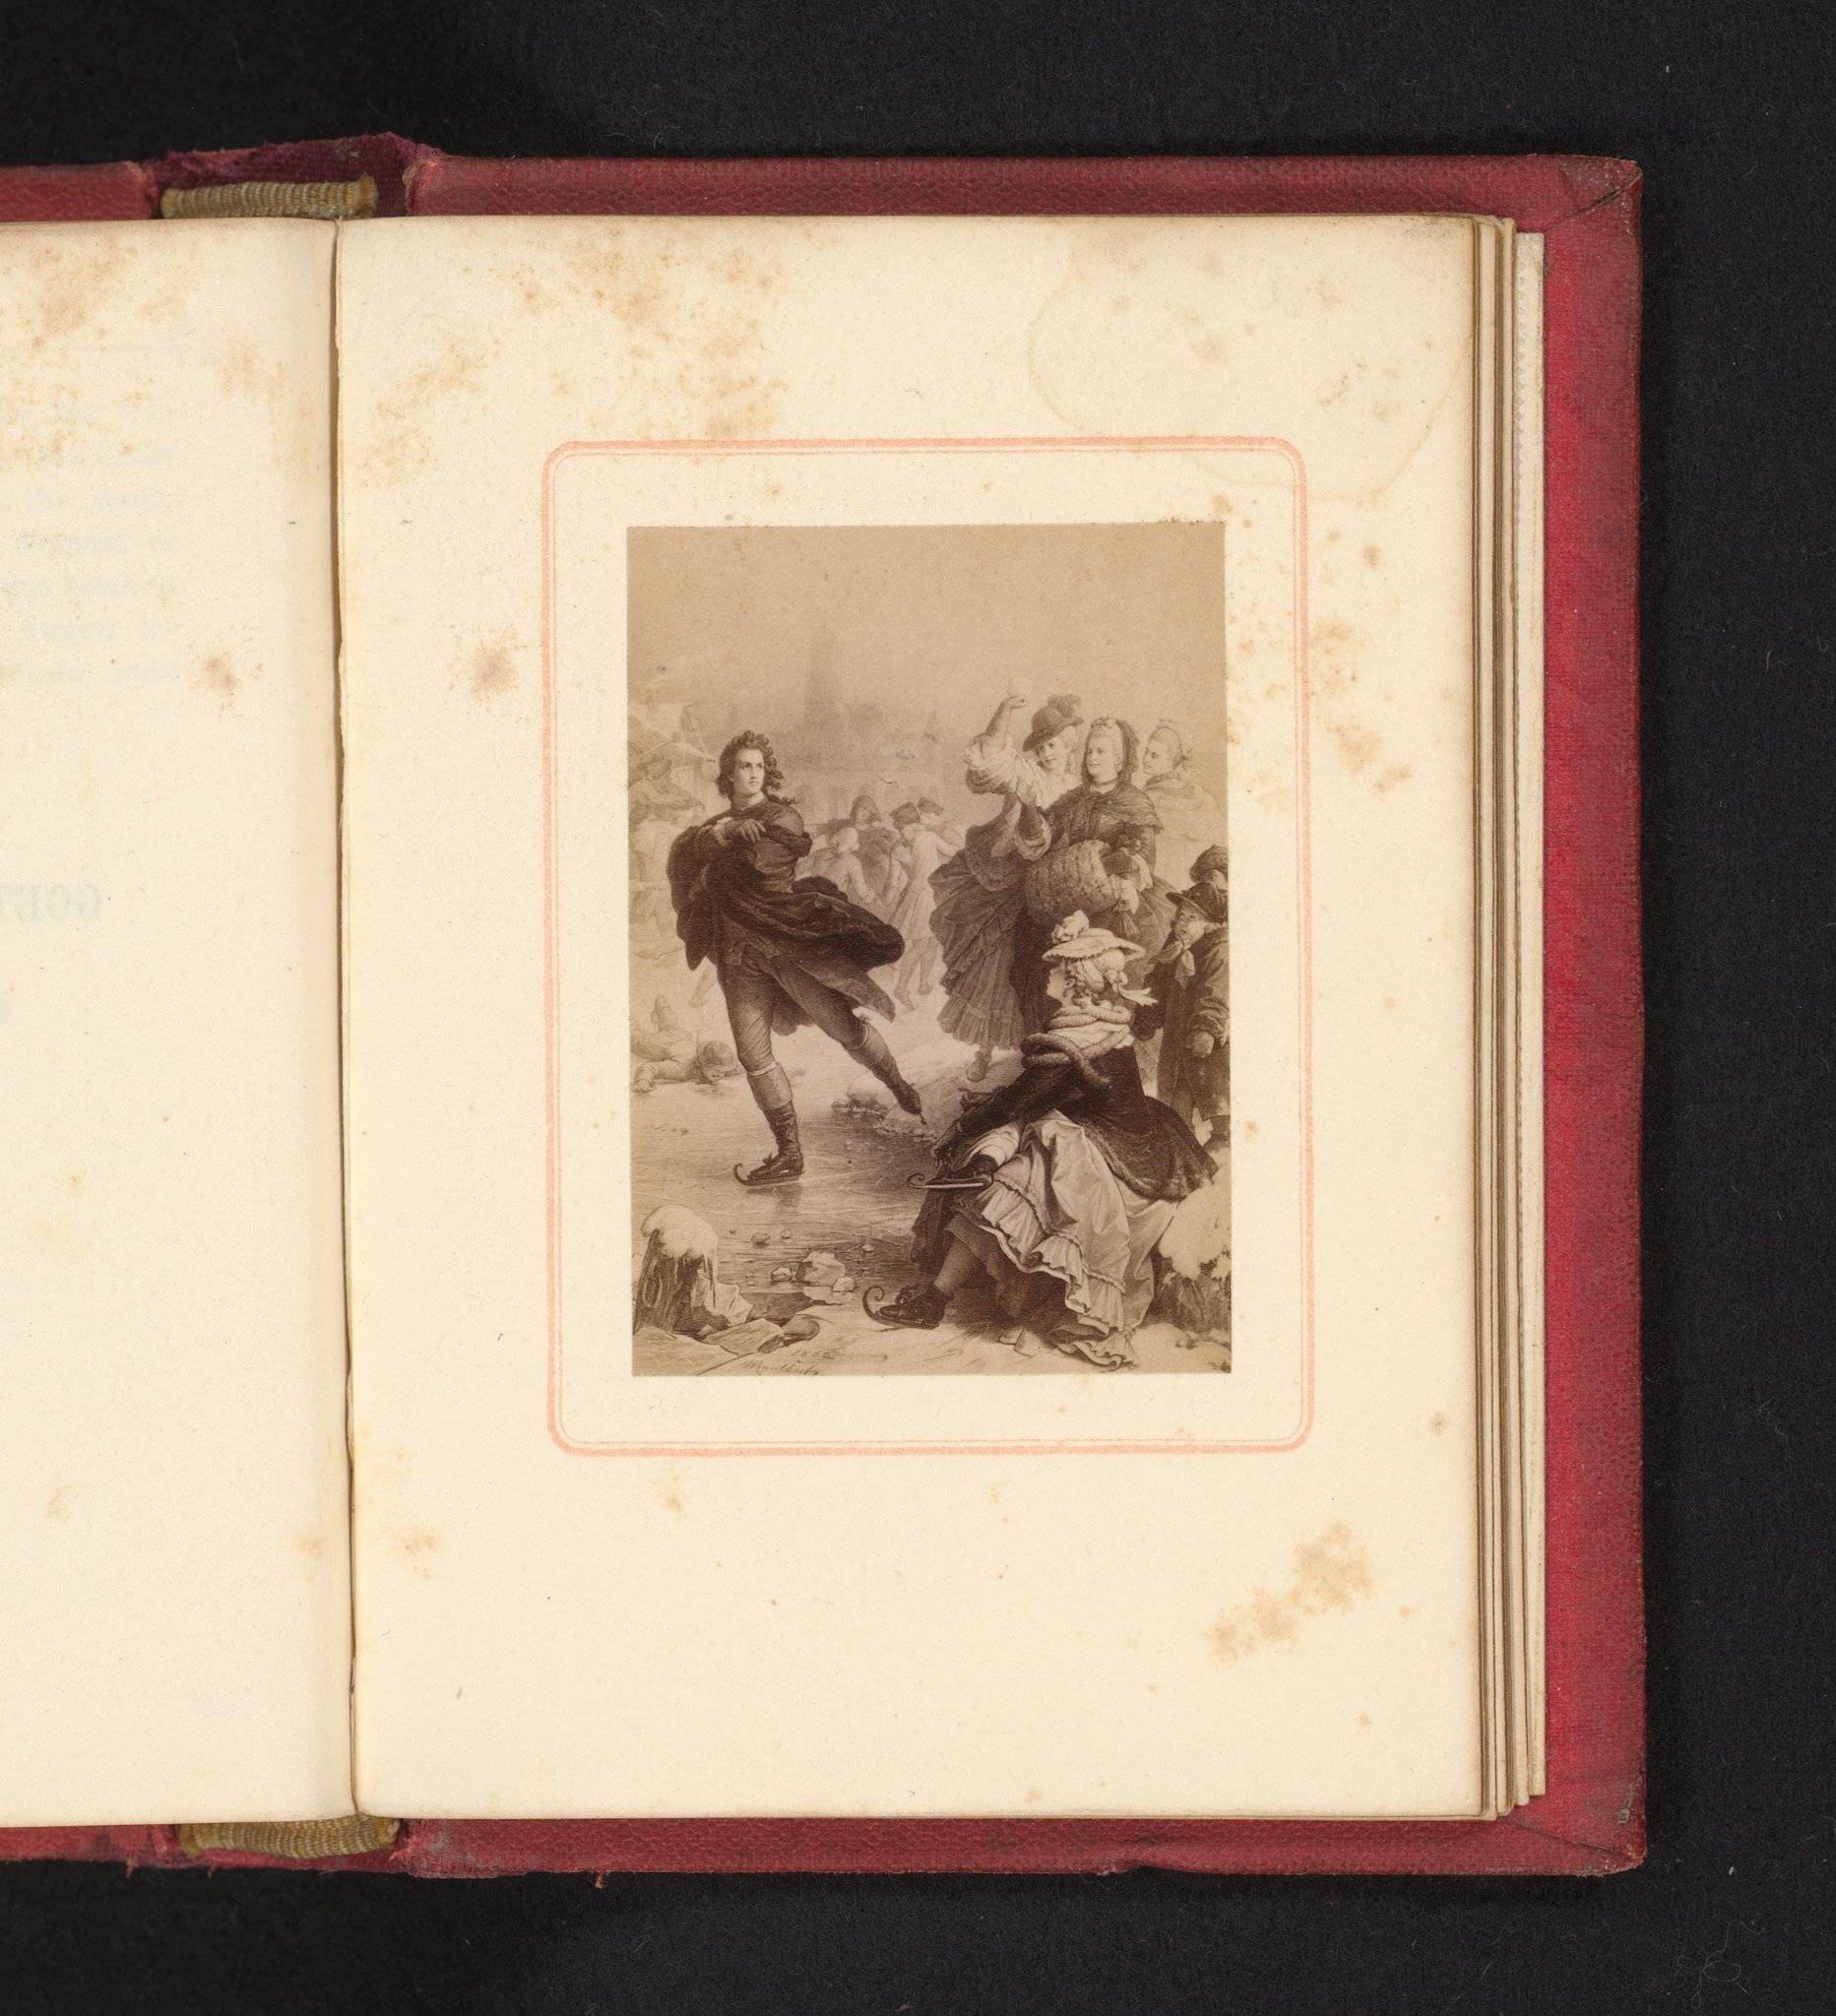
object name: photograph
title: Fotoreproductie van de tekening Goethe in Frankfurt, Wahrheit und Dichtung door Wilhelm von Kaulbach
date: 1863-1870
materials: paper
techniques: albumen print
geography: munich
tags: draughtsman, johann wolfgang von goethe, drawing, sketch